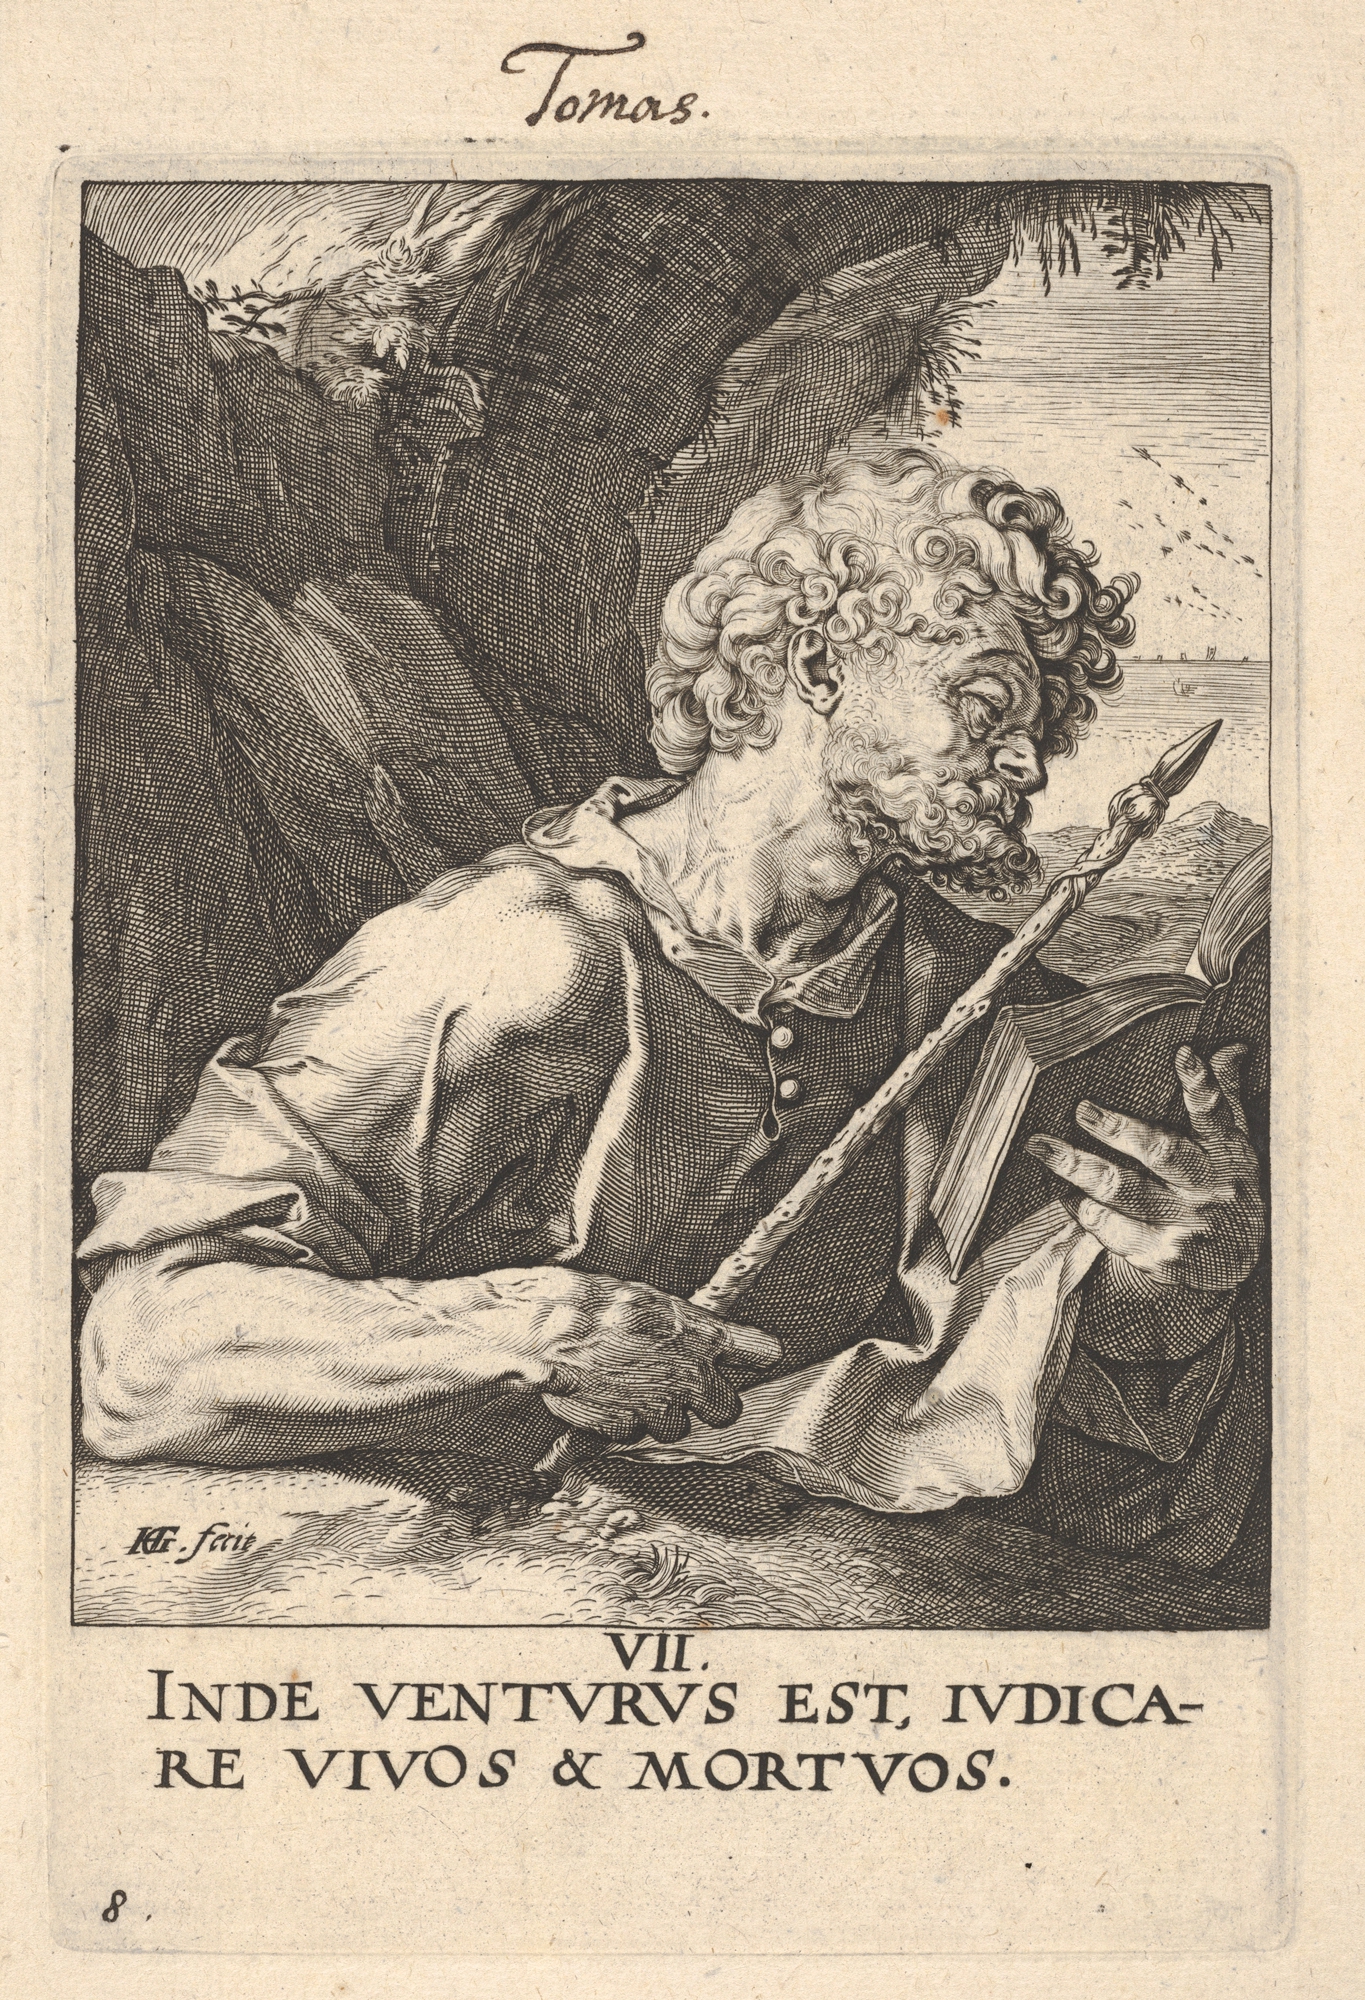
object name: print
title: St. Thomas, from "Christ, the Apostles and St. Paul with the Creed"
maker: hendrick goltzius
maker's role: artist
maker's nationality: netherlandish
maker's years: 1558-1617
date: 1589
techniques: engraving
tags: apostles,saint paul,saints